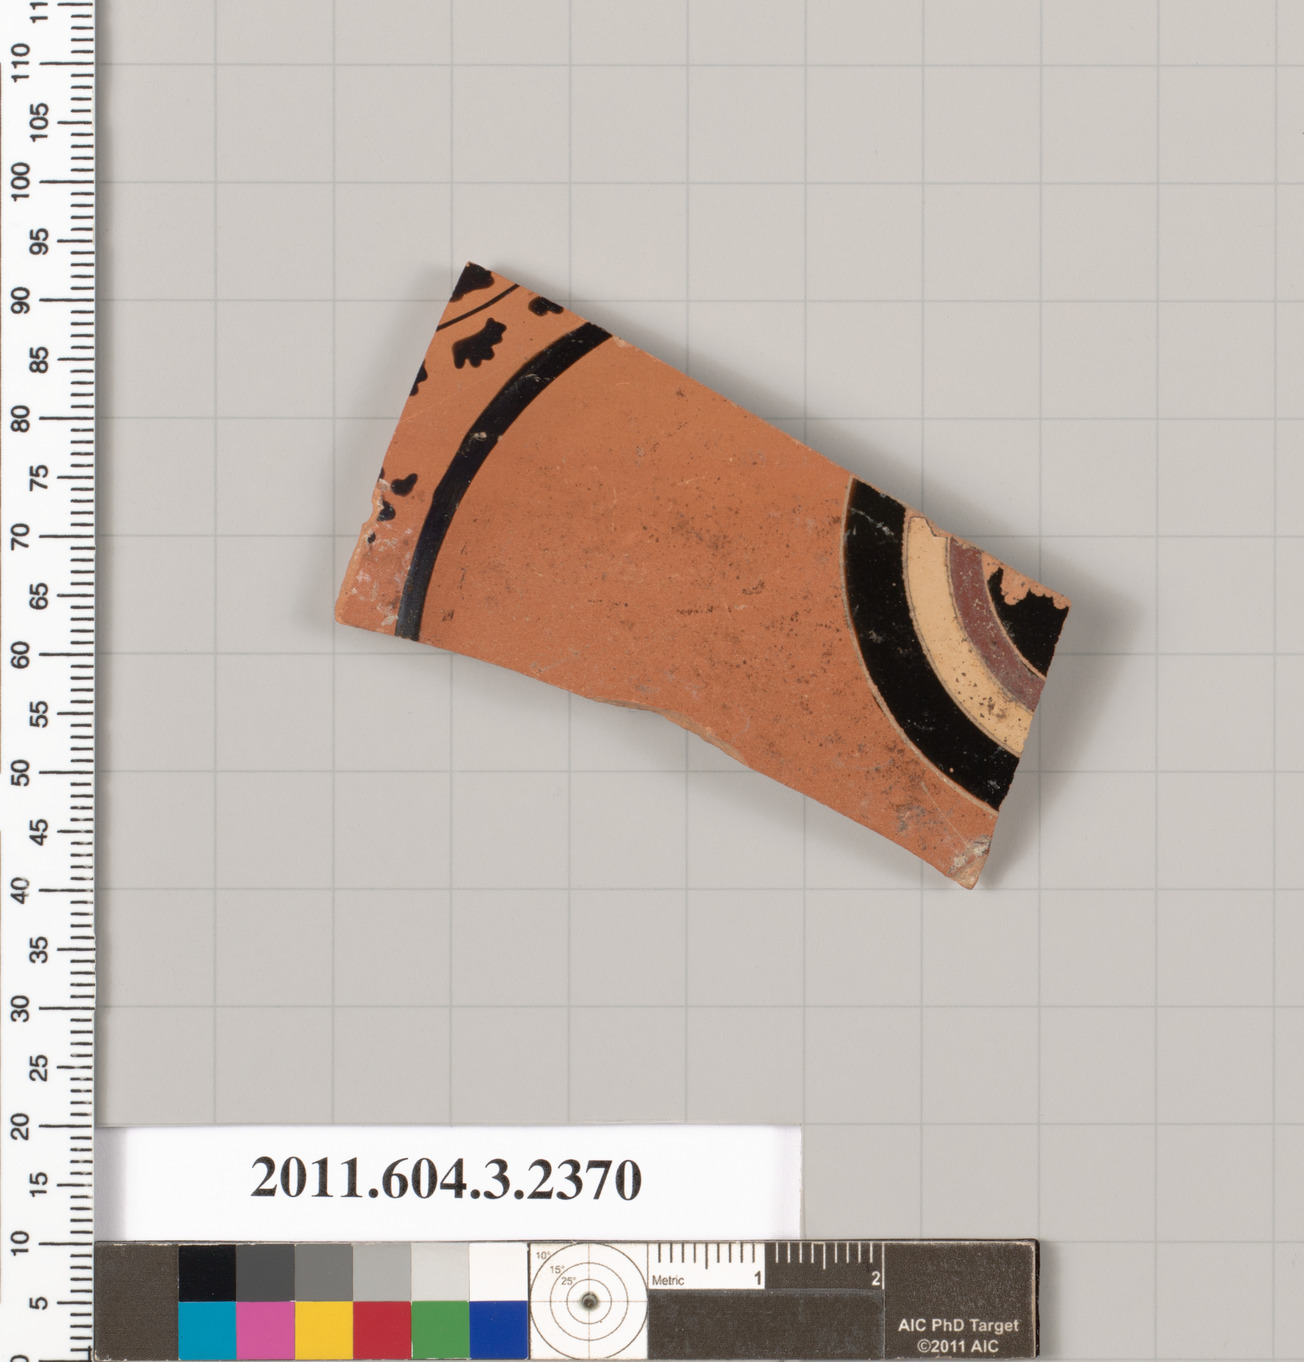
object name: kylix fragment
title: Terracotta fragment of a kylix: eye-cup (drinking cup)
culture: greek, attic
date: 540-520 BCE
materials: terracotta